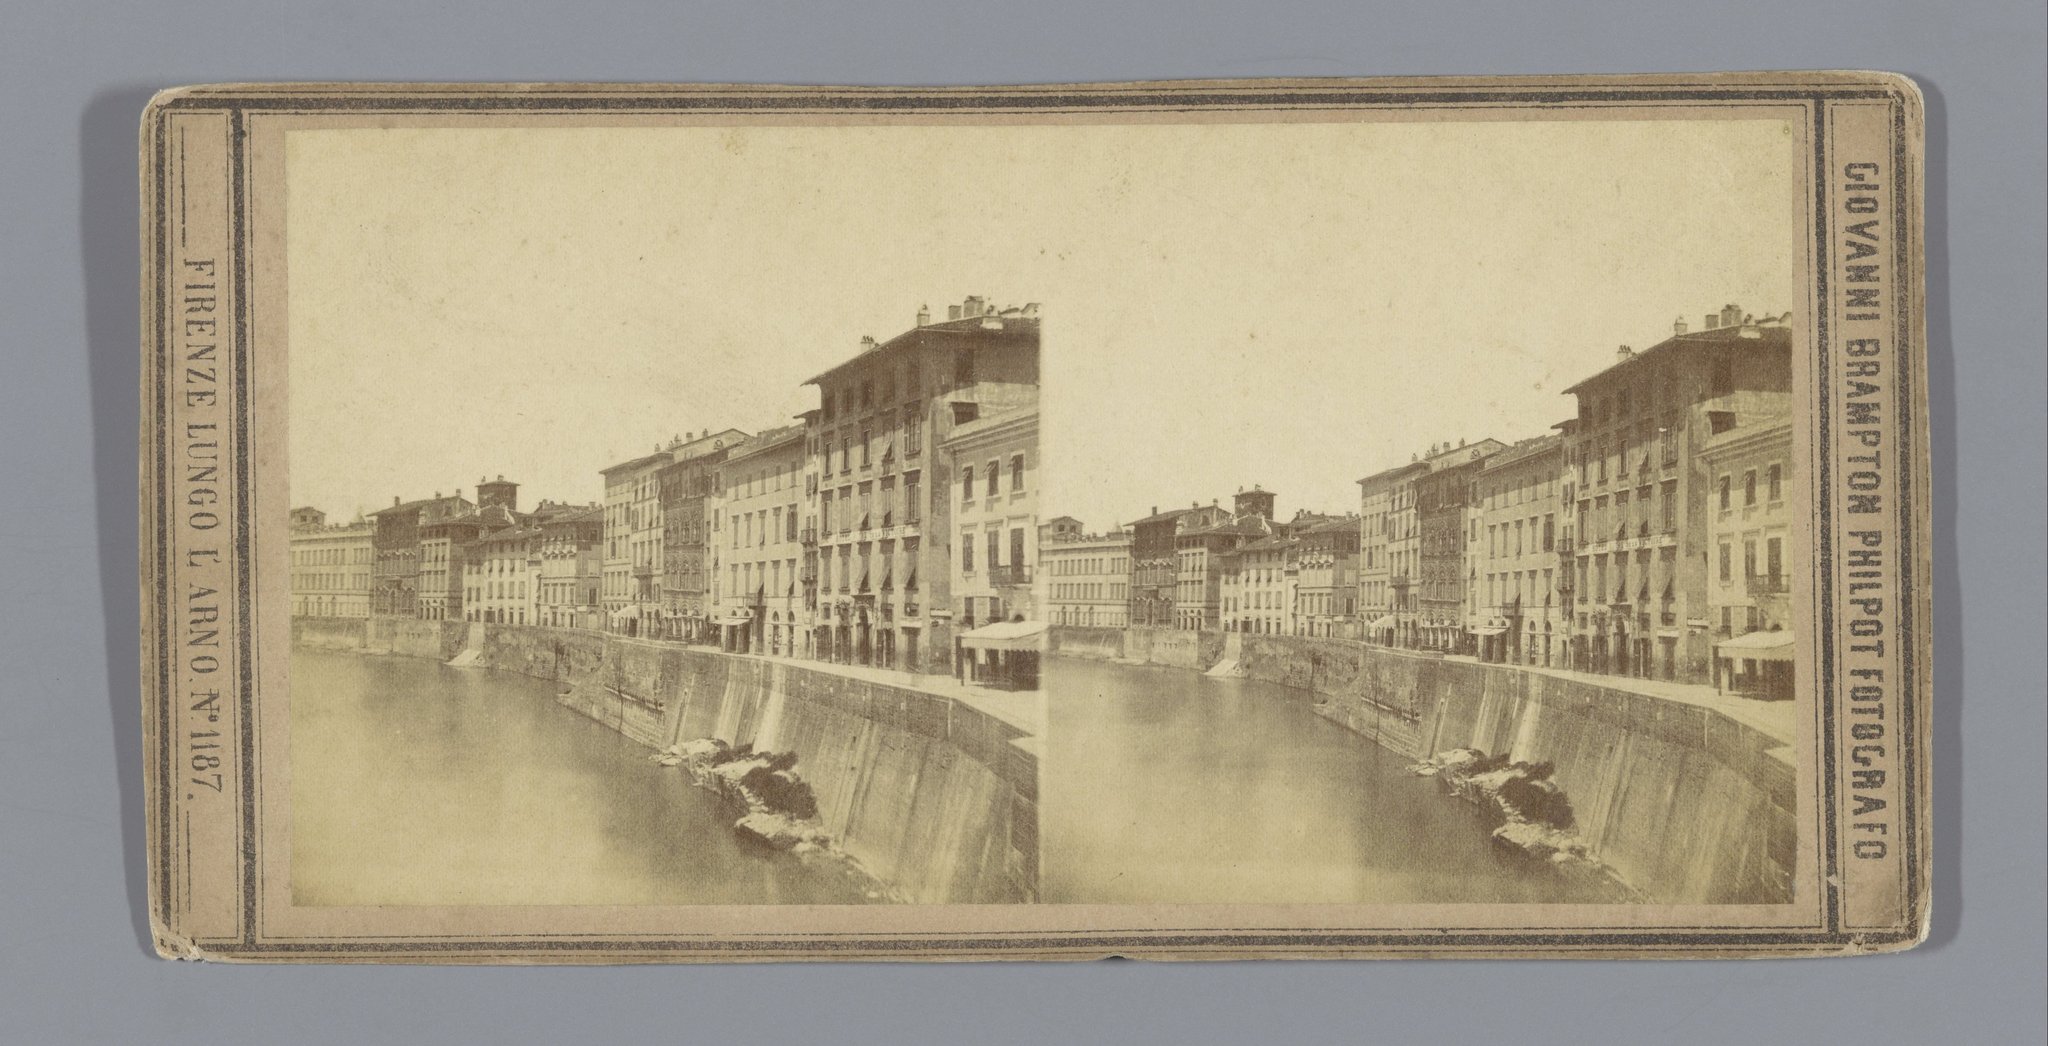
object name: stereograph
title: Kade langs de Arno te Pisa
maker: giovanni brampton philpot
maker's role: publisher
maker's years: 1812-1878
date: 1850-1870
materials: cardboard, photographic support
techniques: albumen print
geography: pisa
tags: river, façade (of house or building), quay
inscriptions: inscription: ‘Pisa Lung'Arno’, name: ‘GIOVANNI BRAMPTON PHILPOT FOTOGRAFO FIRENZE LUNGO L'ARNO No. 1187.’